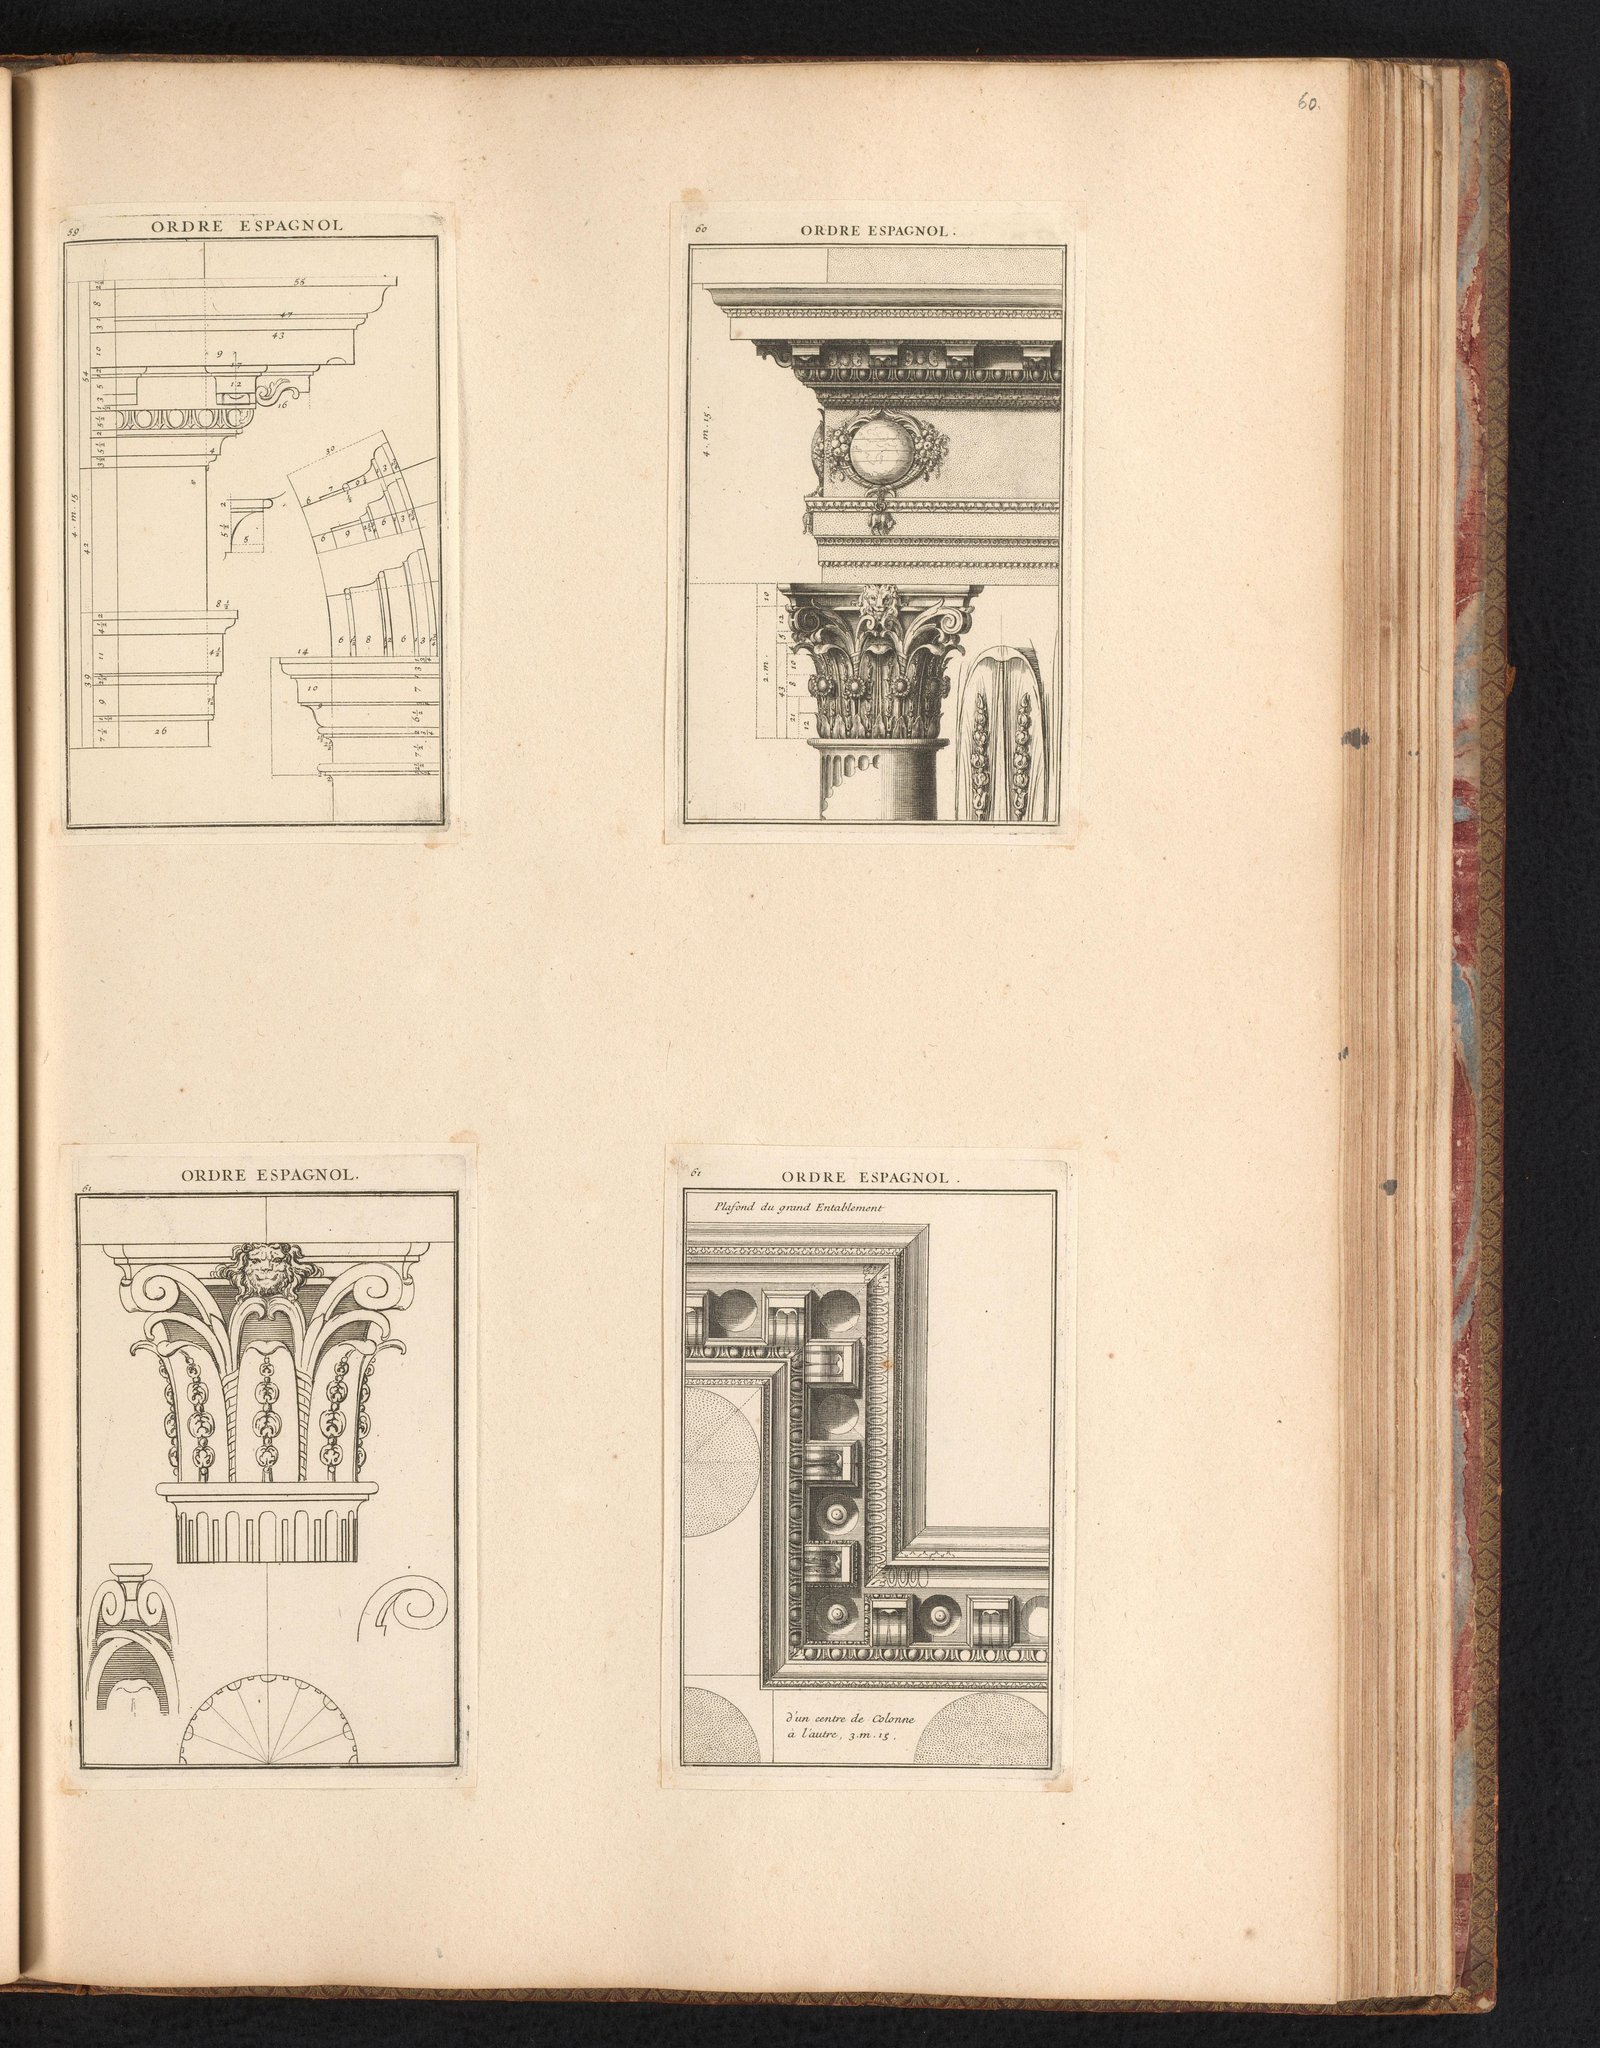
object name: book illustration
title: Ordre Espagnol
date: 1714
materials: paper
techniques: etching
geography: paris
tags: orders, order-books ~ architecture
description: Prenten uit: Leclerc, Sébastien (I). Traité d'architecture. Parijs: Pierre François Giffart, 1714.